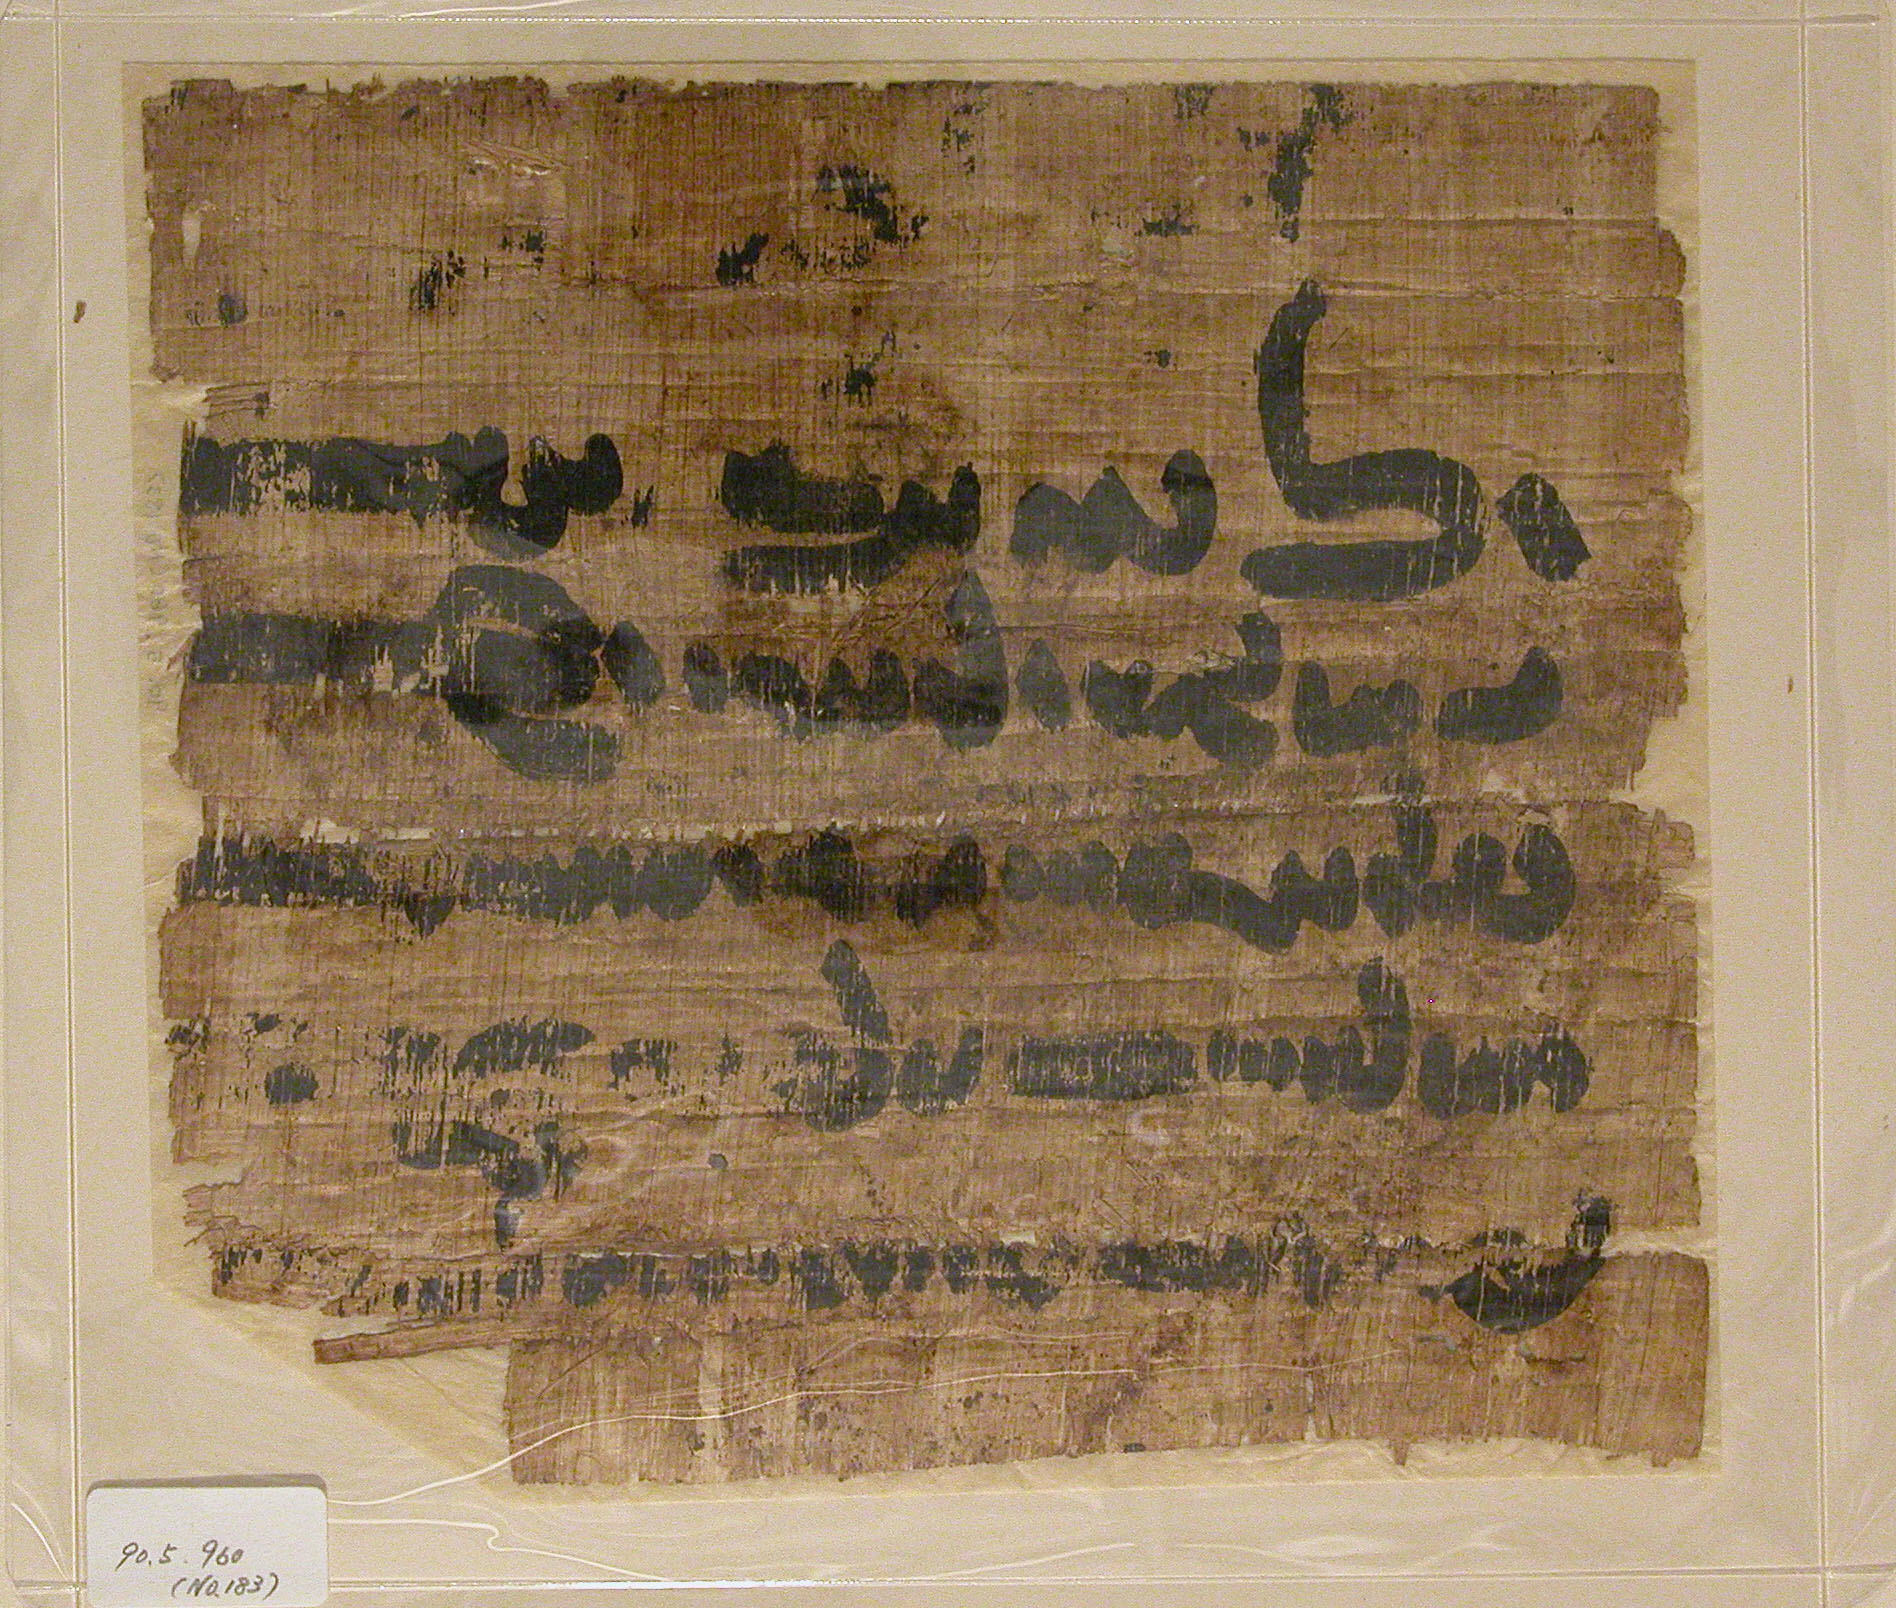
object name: non illustrated single work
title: Letter in Pahlavi script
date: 601-633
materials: ink, papyrus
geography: egypt